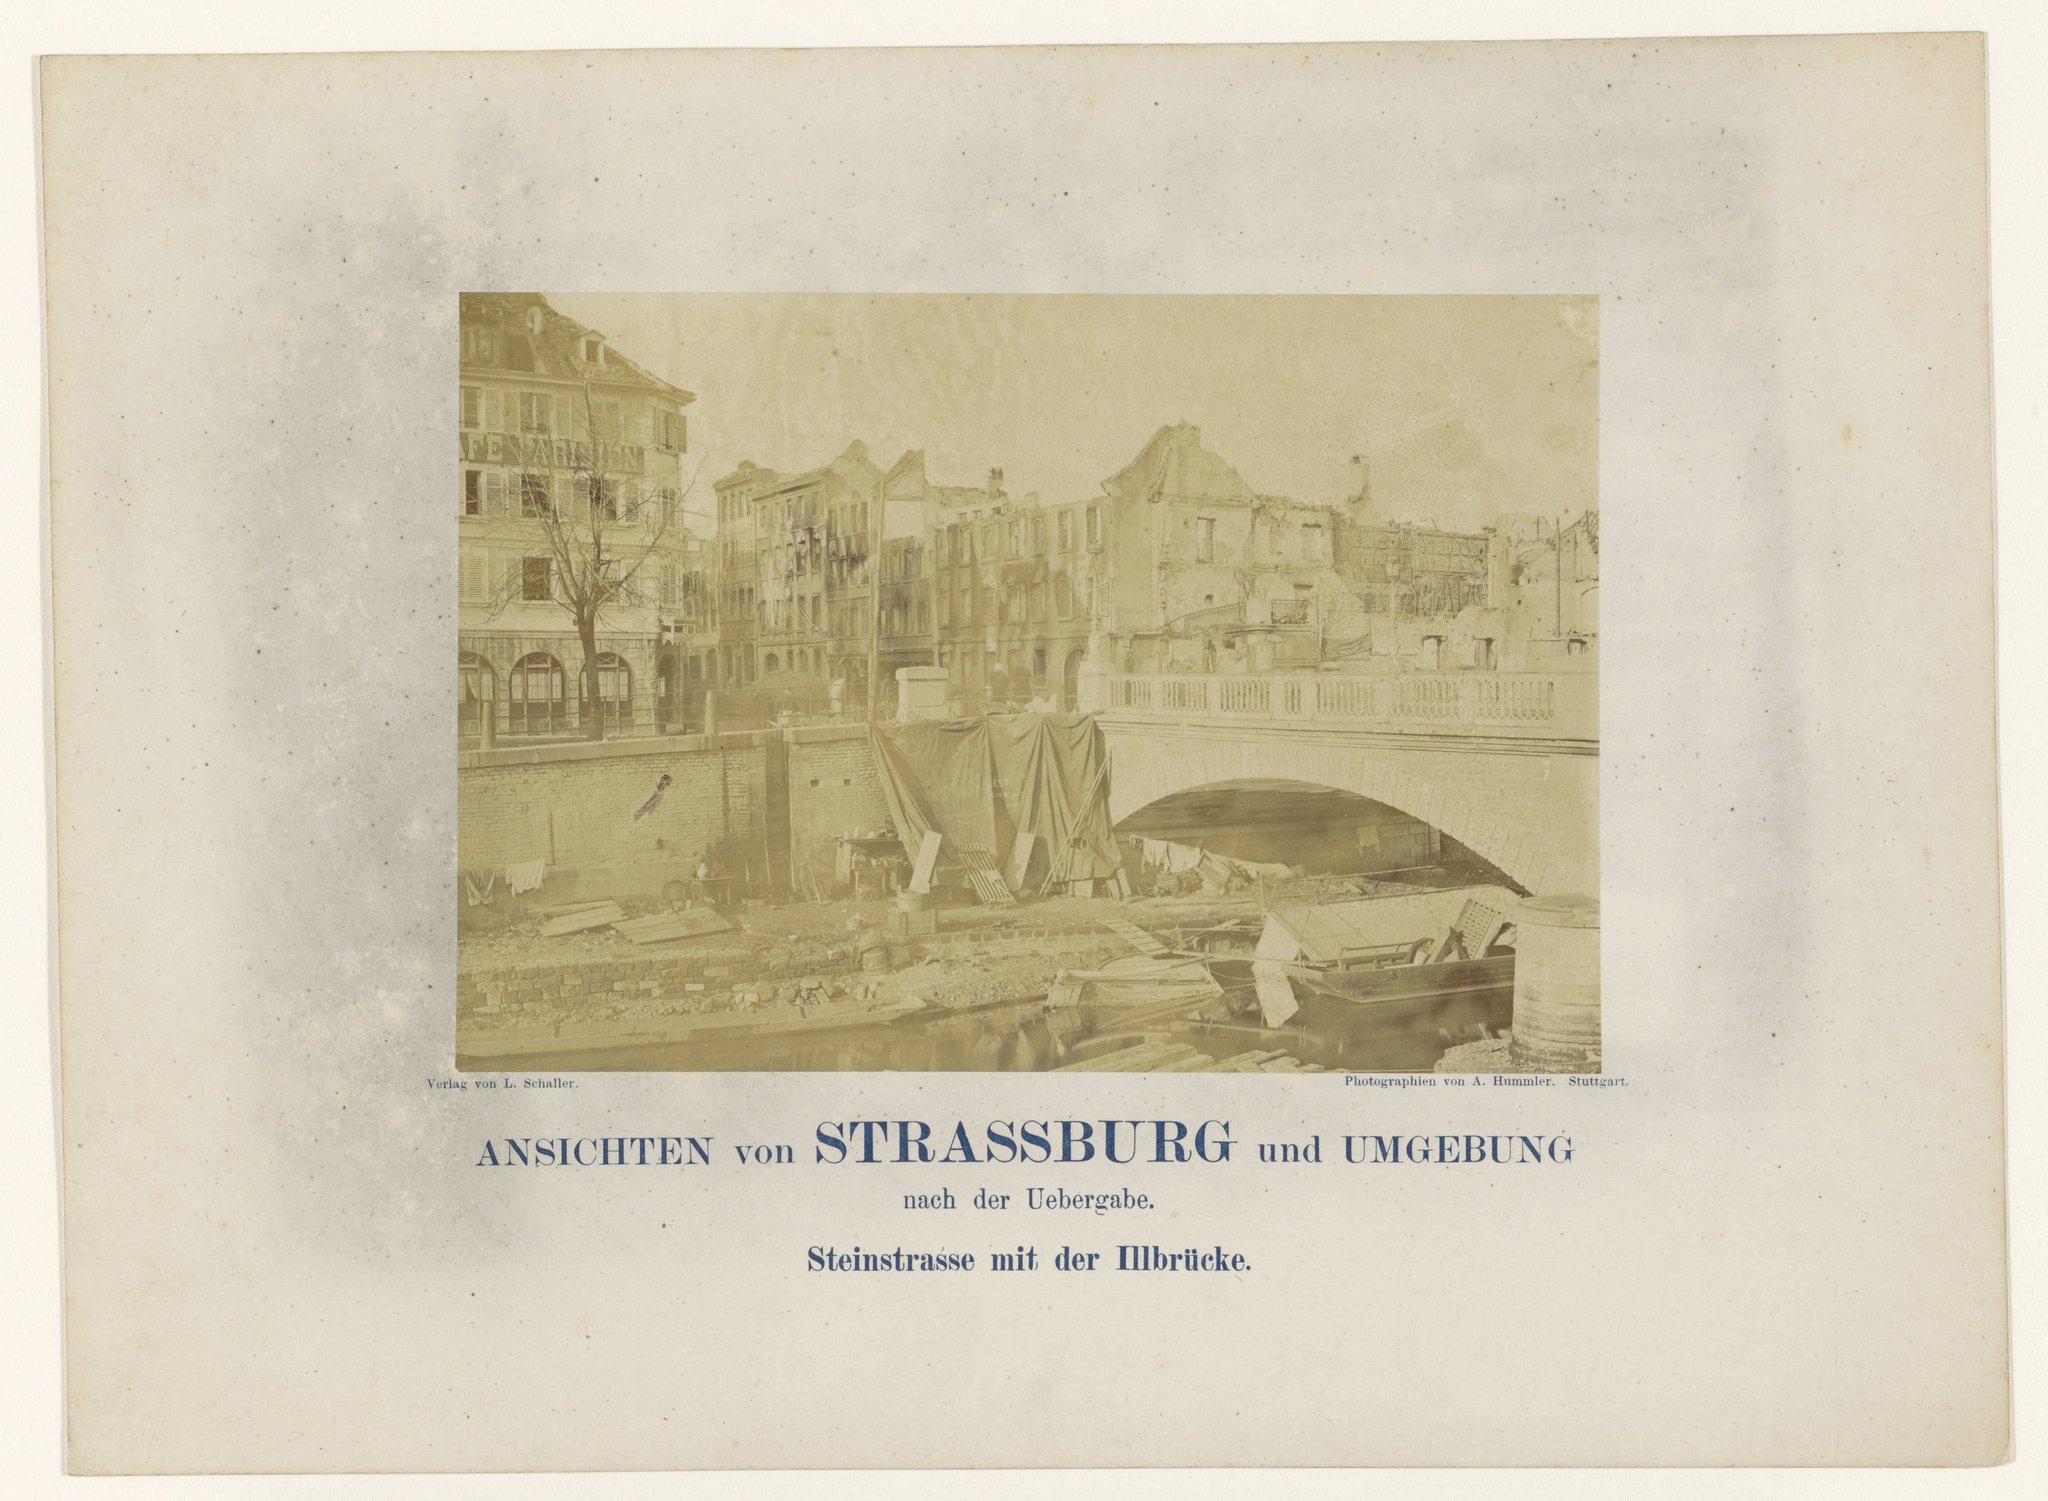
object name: photograph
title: Verwoestingen in de Steinstraße in Straatsburg na gevechten van de Frans-Duitse oorlog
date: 1870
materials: cardboard, paper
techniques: albumen print, letterpress printing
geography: straatsburg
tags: devastated, ruined place or city (~ warfare)